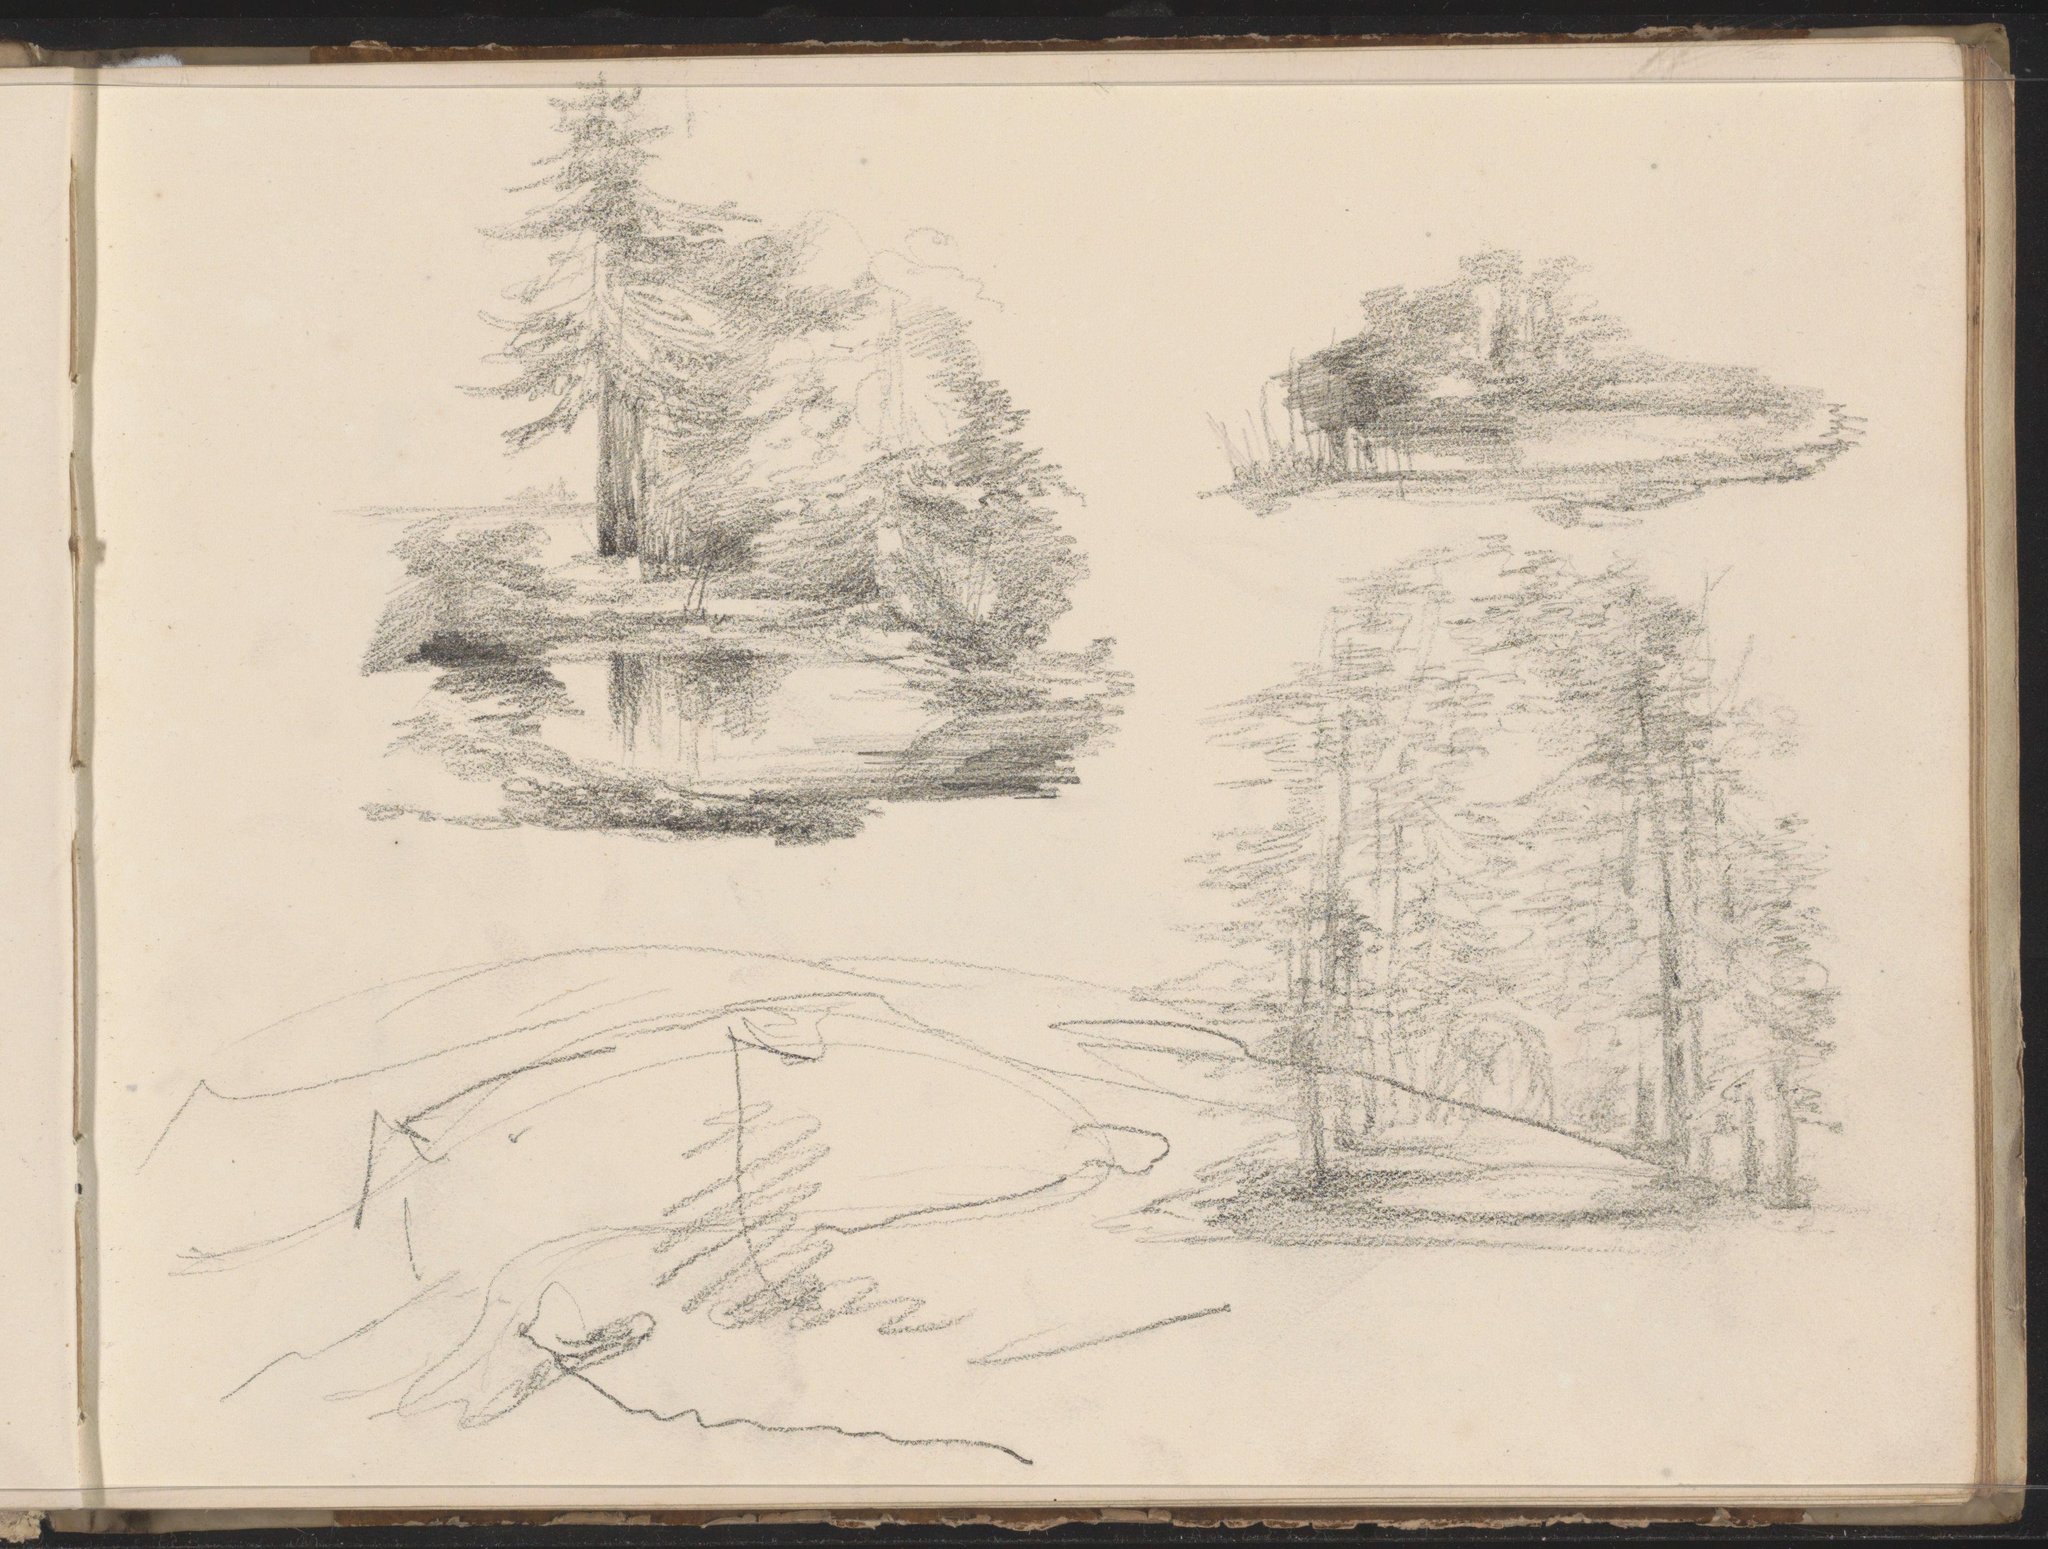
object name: sketchbook leaf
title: Bomen aan een waterkant en een bospad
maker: maria vos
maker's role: draughtsman, painter, print maker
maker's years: 1824-1906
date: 1834-1906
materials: paper, pencil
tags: landscapes with waters, waterscapes, seascapes (in the temperate zone), forest, wood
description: Blad 4 recto uit een schetsboek met 39 bladen.